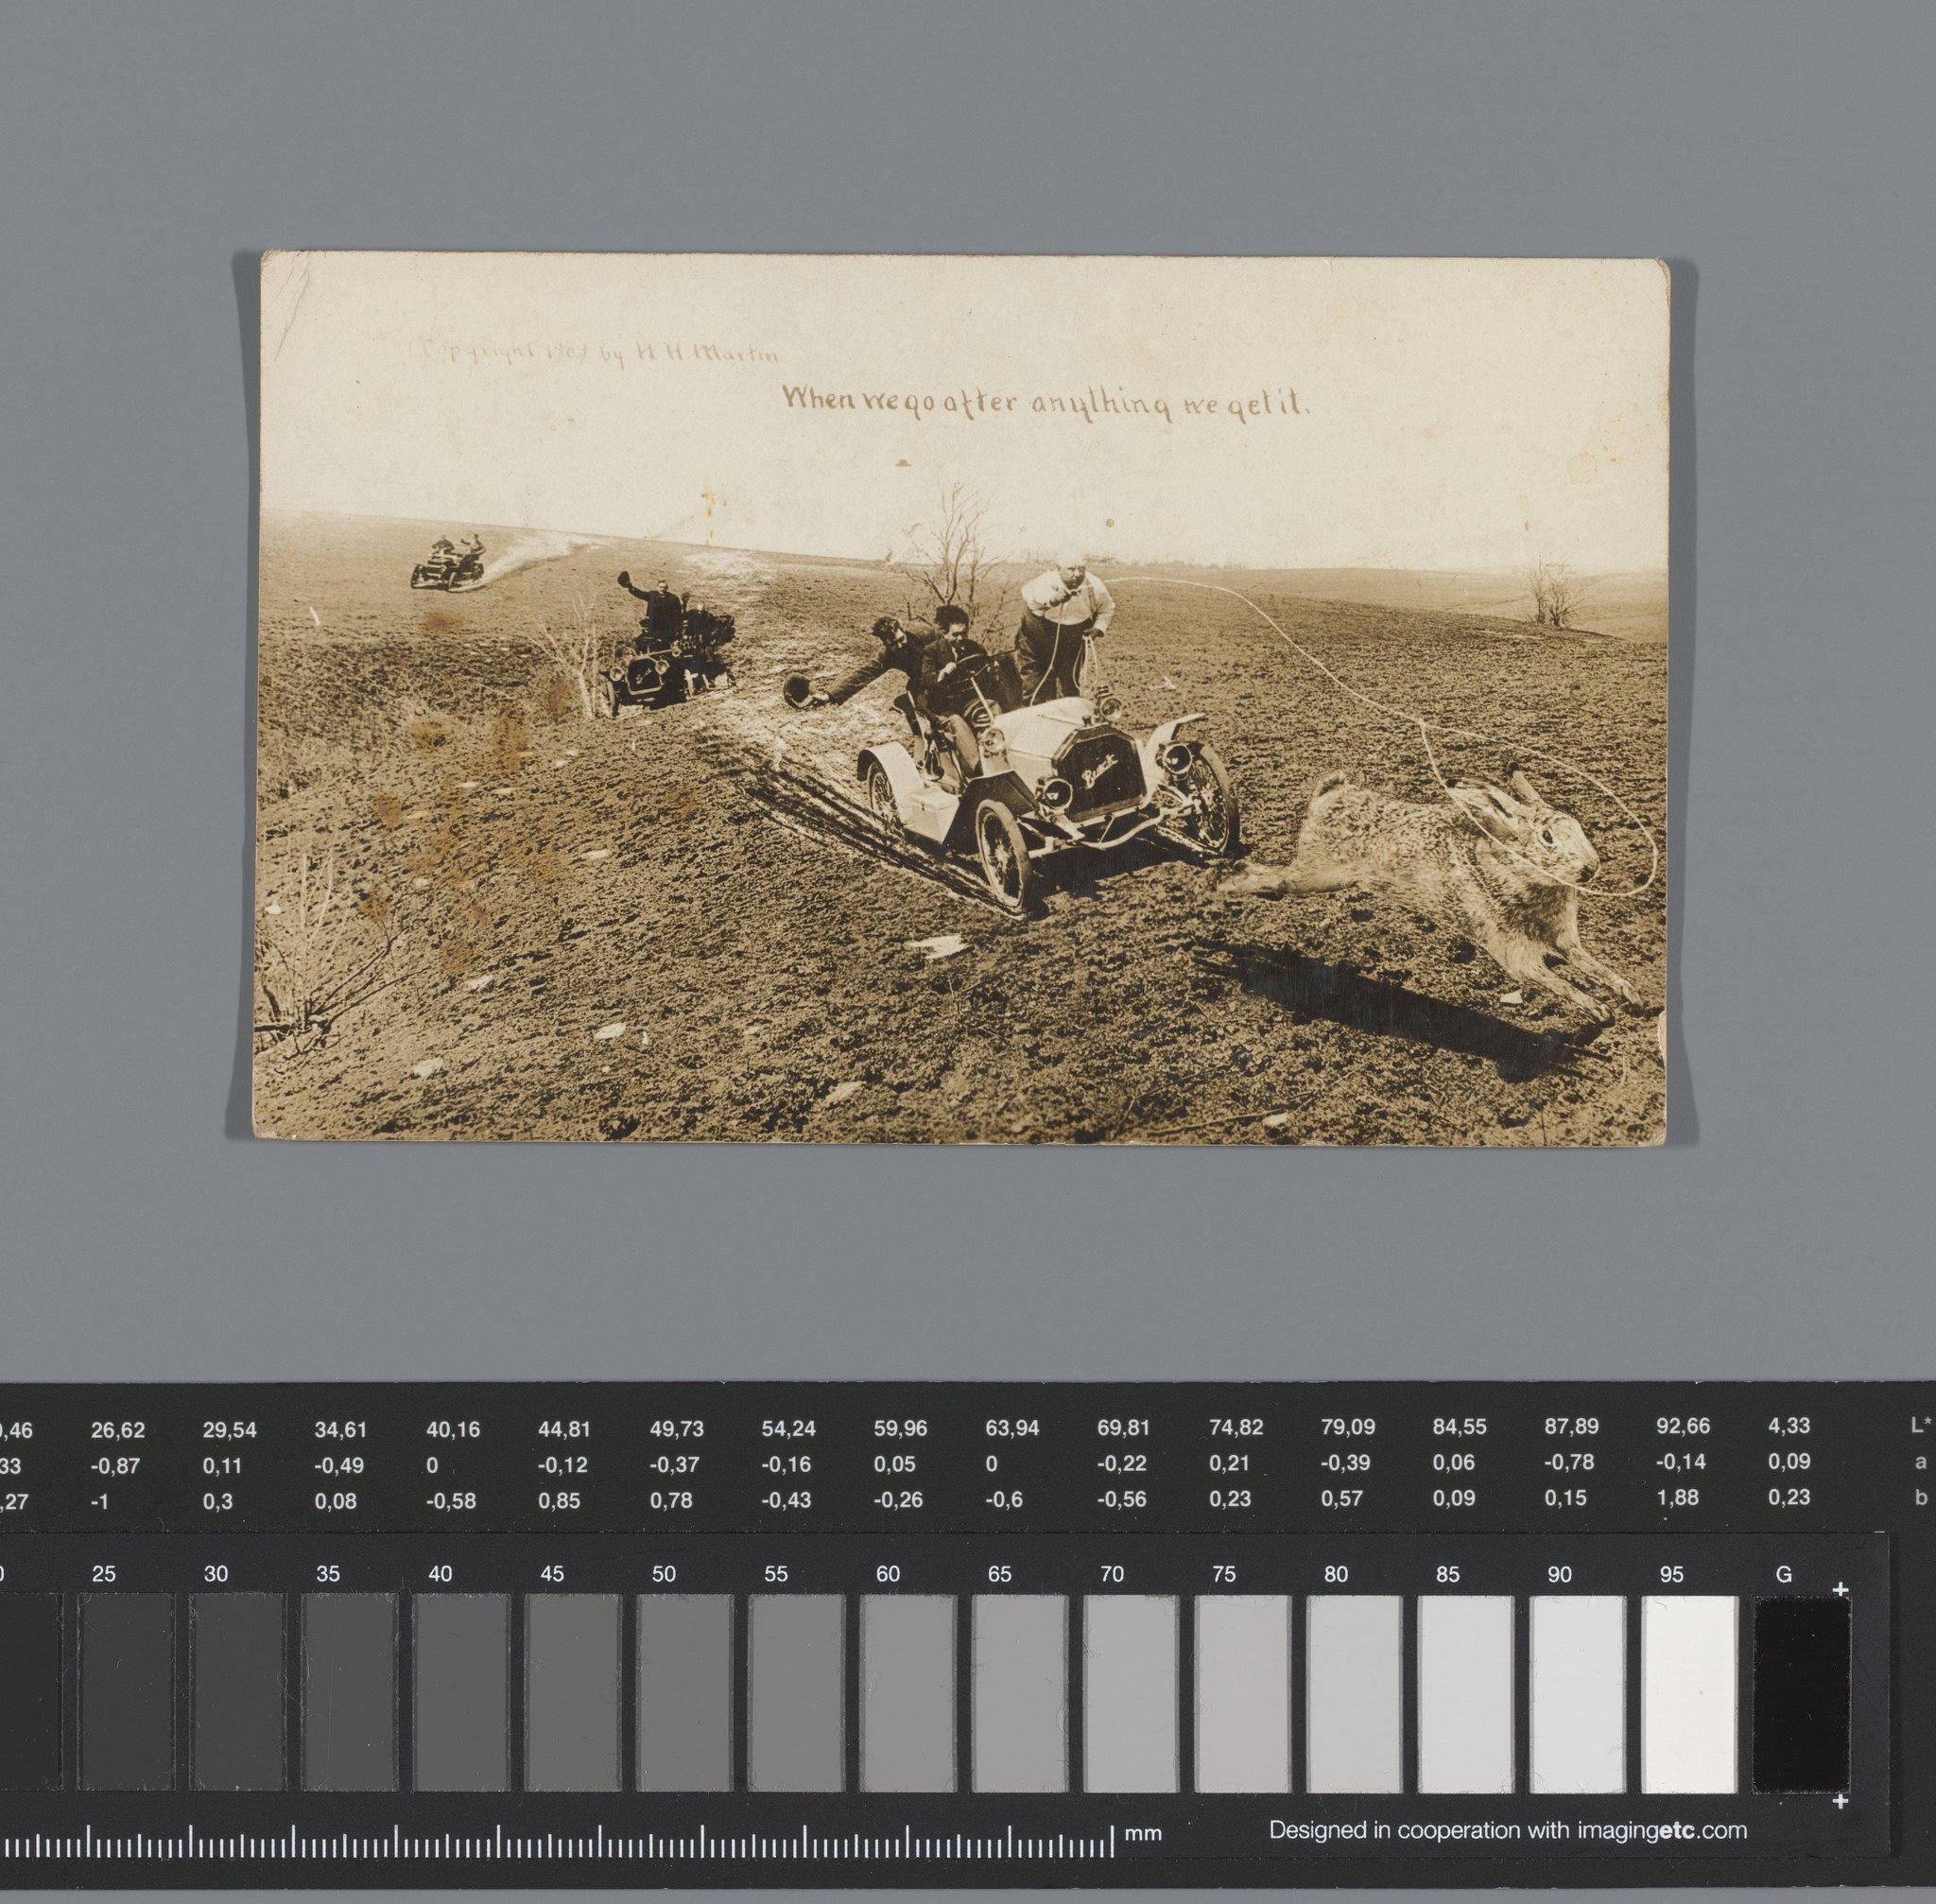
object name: ansichtkaart, prentbriefkaart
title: When we go after anything we get it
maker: william h. martin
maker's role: fotograaf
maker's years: 1865-1940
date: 1909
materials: paper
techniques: gelatin silver print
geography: united states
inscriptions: inscription: ‘Mr Levu Butker / Carthage / Ind. // Pendleton [?] / Jan 31-1911 / Dear Father. / I am having / a nice little visit / with the folks, feeling / as wild as usual. / Hope you are well / with love / Harriett’, inscription: ‘PUBLISHED BY / THE NORTH AMERICAN POST CARD CO. / KANSAS CITY, U.S.A.’, inscription: ‘Copyright 1909 by W.H. Martin / When we go after anything we get it.’